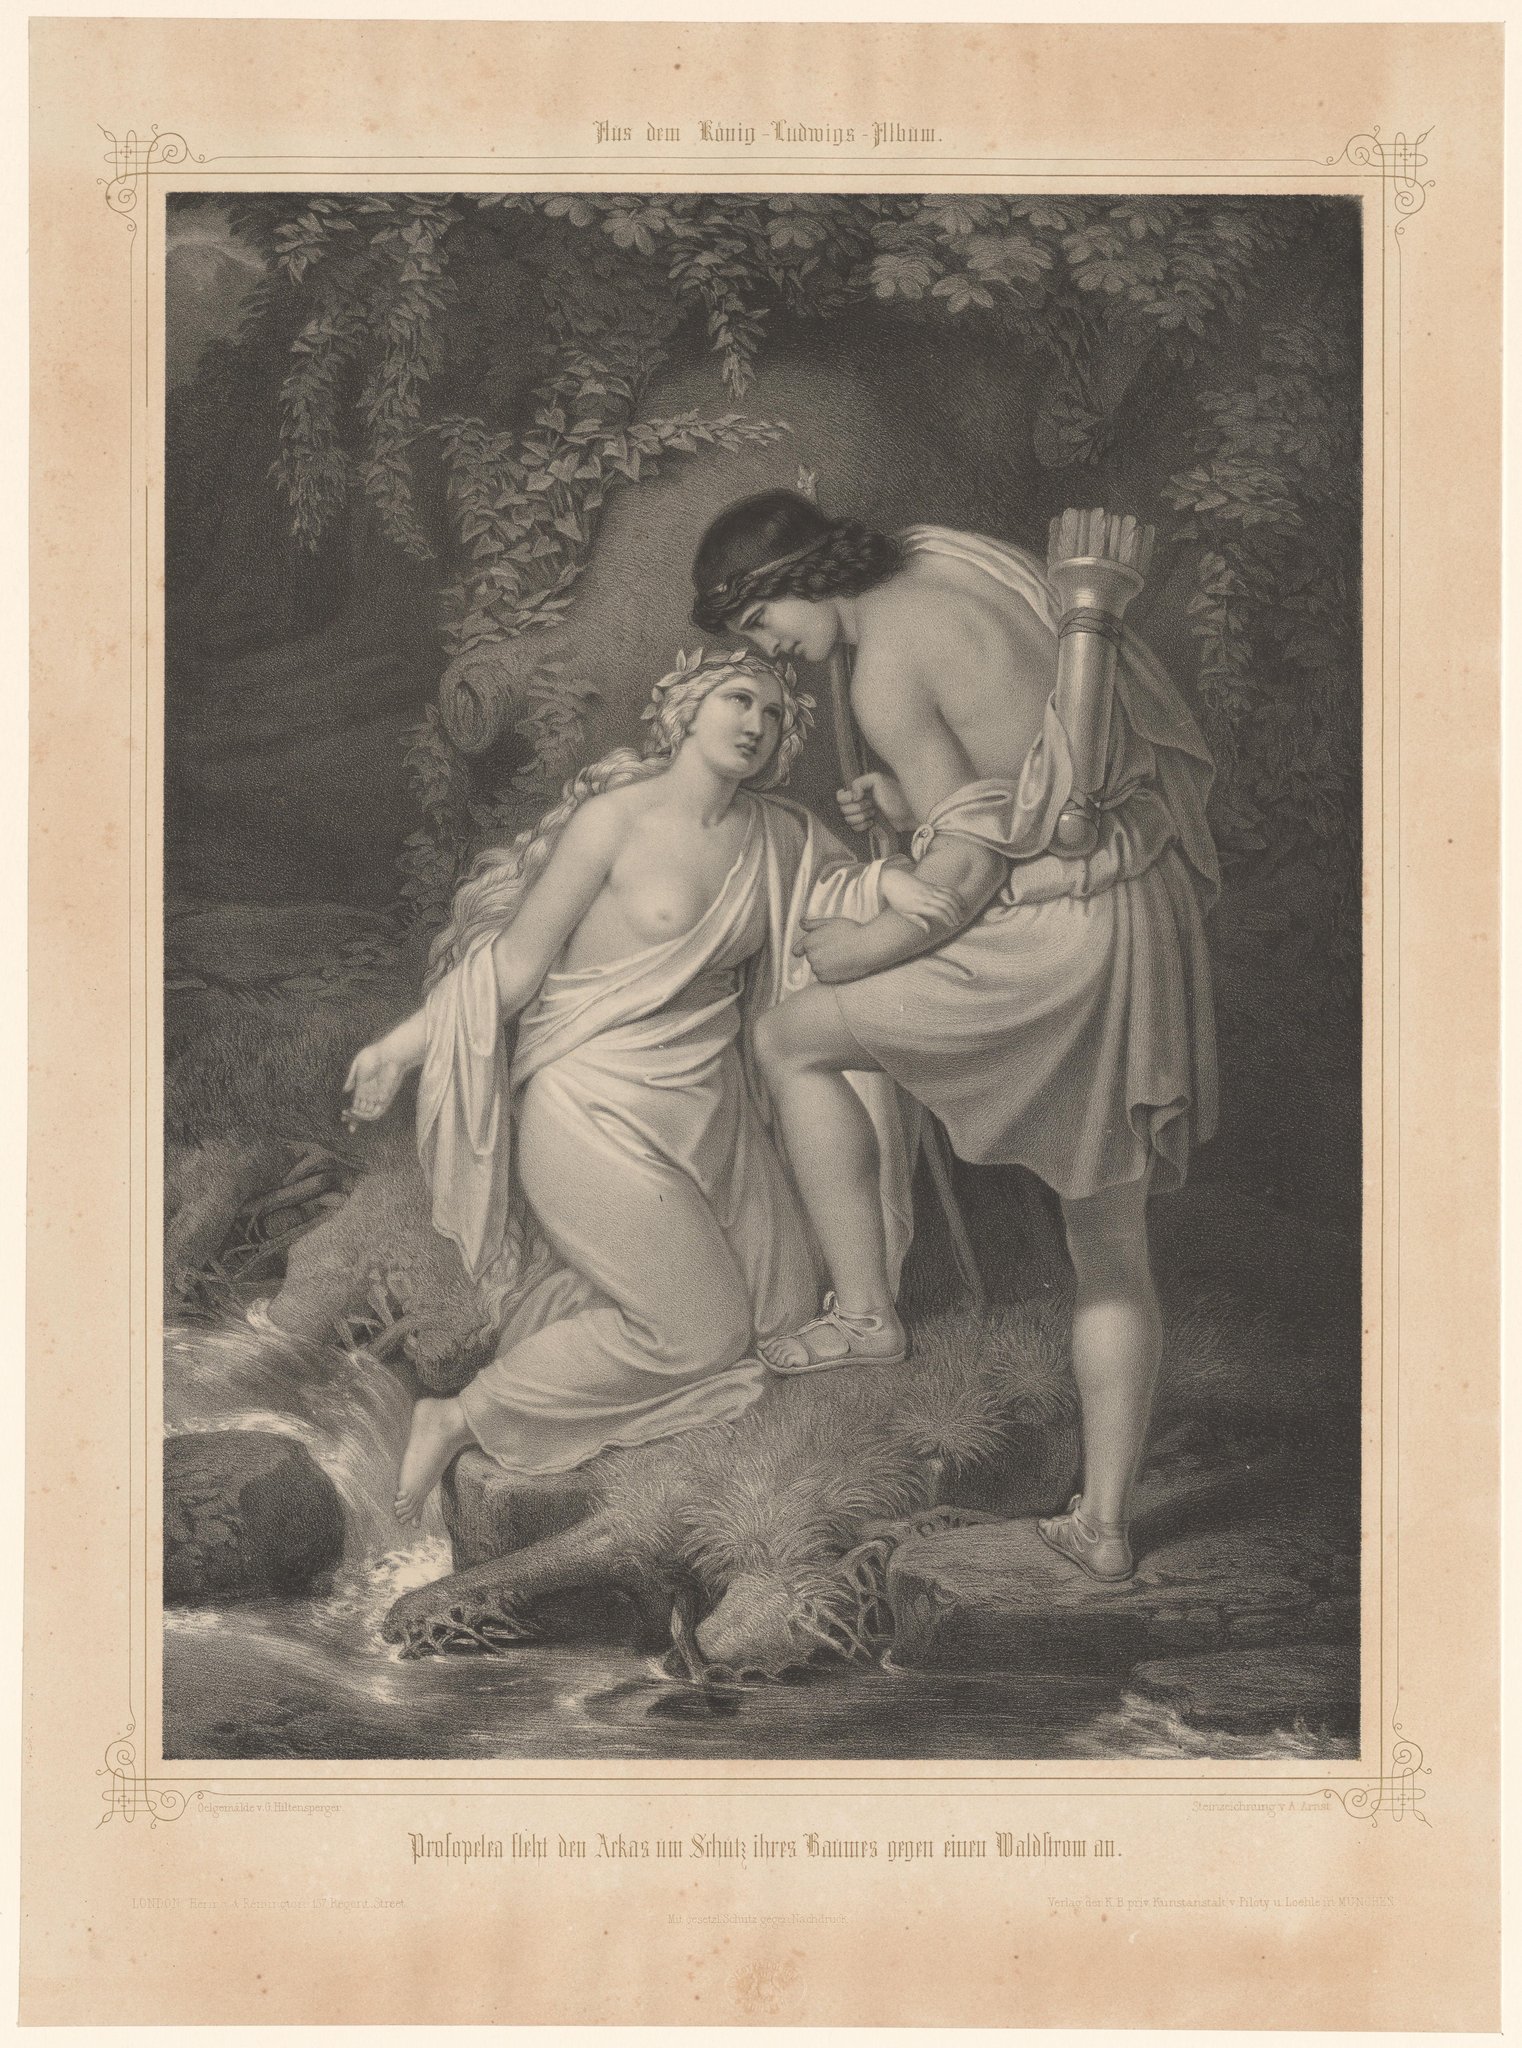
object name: print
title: Prosopelea fleht den Arkas um Schutz ihres Baumes gegen einen Waldstrom an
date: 1850-1870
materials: paper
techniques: tone lithography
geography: london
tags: trees, hunter, nymphs (in general); 'ninfe in commune' (ripa), classical mythology and ancient history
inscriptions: check stamp: ‘Piloty & Loehle München’, collector's mark: Lugt 2228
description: Prent maakt waarschijnlijk deel uit van de serie 'König-Ludwigs-Albums'.